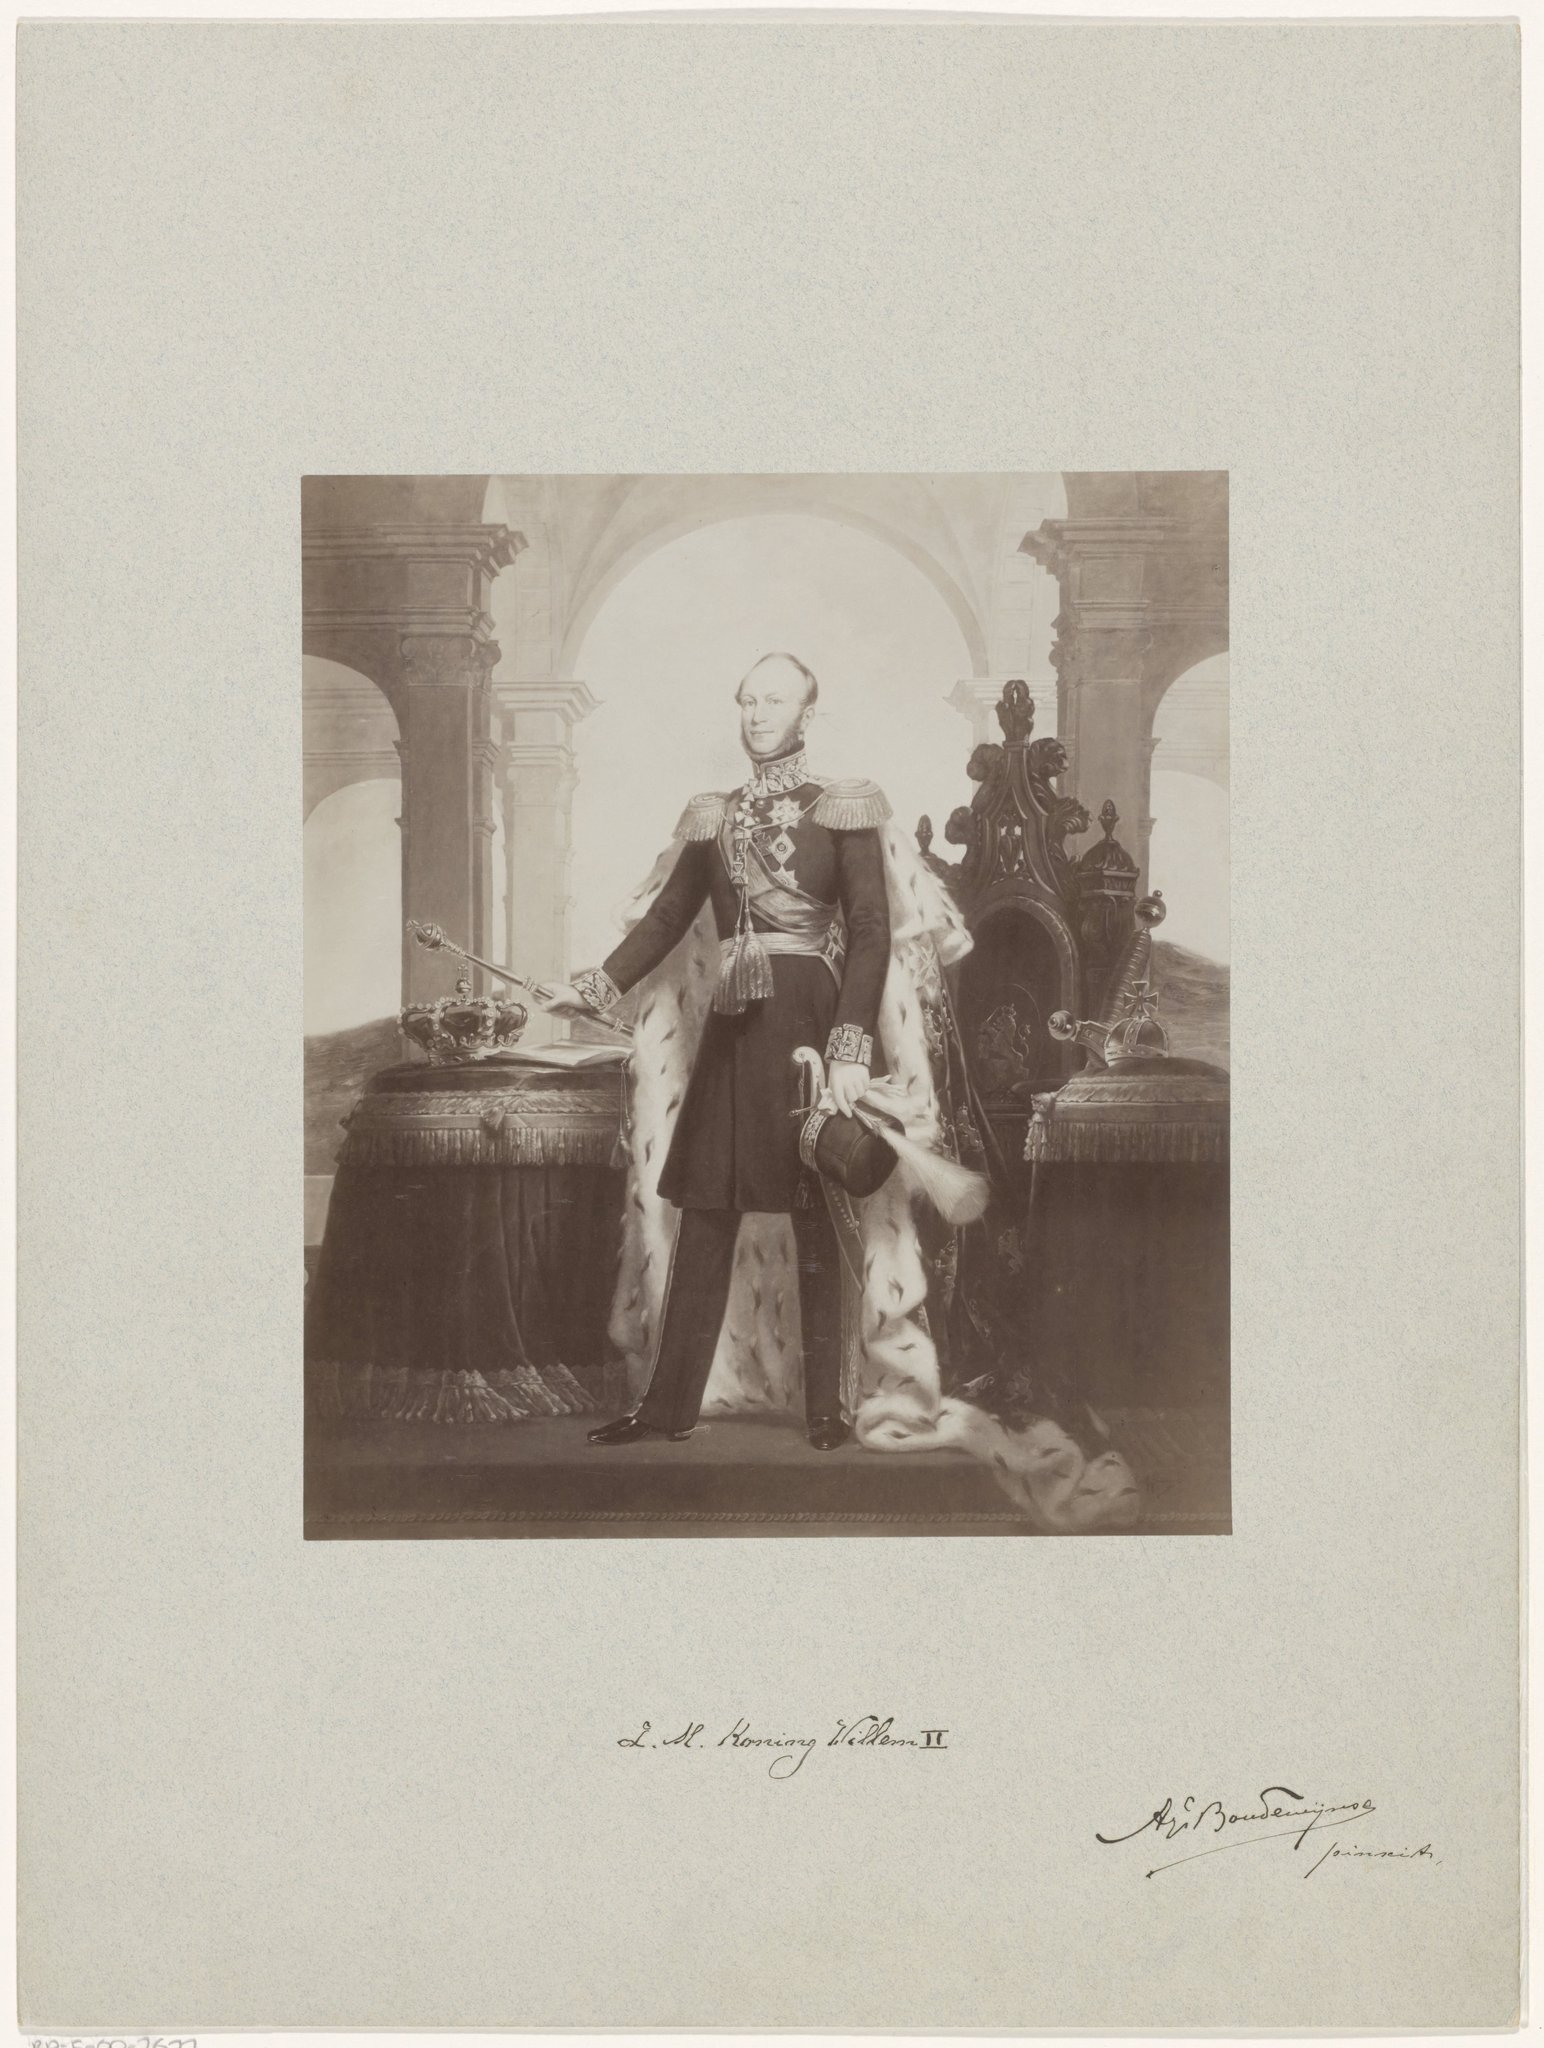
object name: photograph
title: Portret van Willem II, koning der Nederlanden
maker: Anonymous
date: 1850-1930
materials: photographic support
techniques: photography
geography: netherlands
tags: william ii of the netherlands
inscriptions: collector's mark: Lugt 2228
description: De hier vermelde titel verwijst naar de hoogst verkregen titel van de geportretteerde, niet per se naar de titel die de geportretteerde op deze voorstelling draagt.